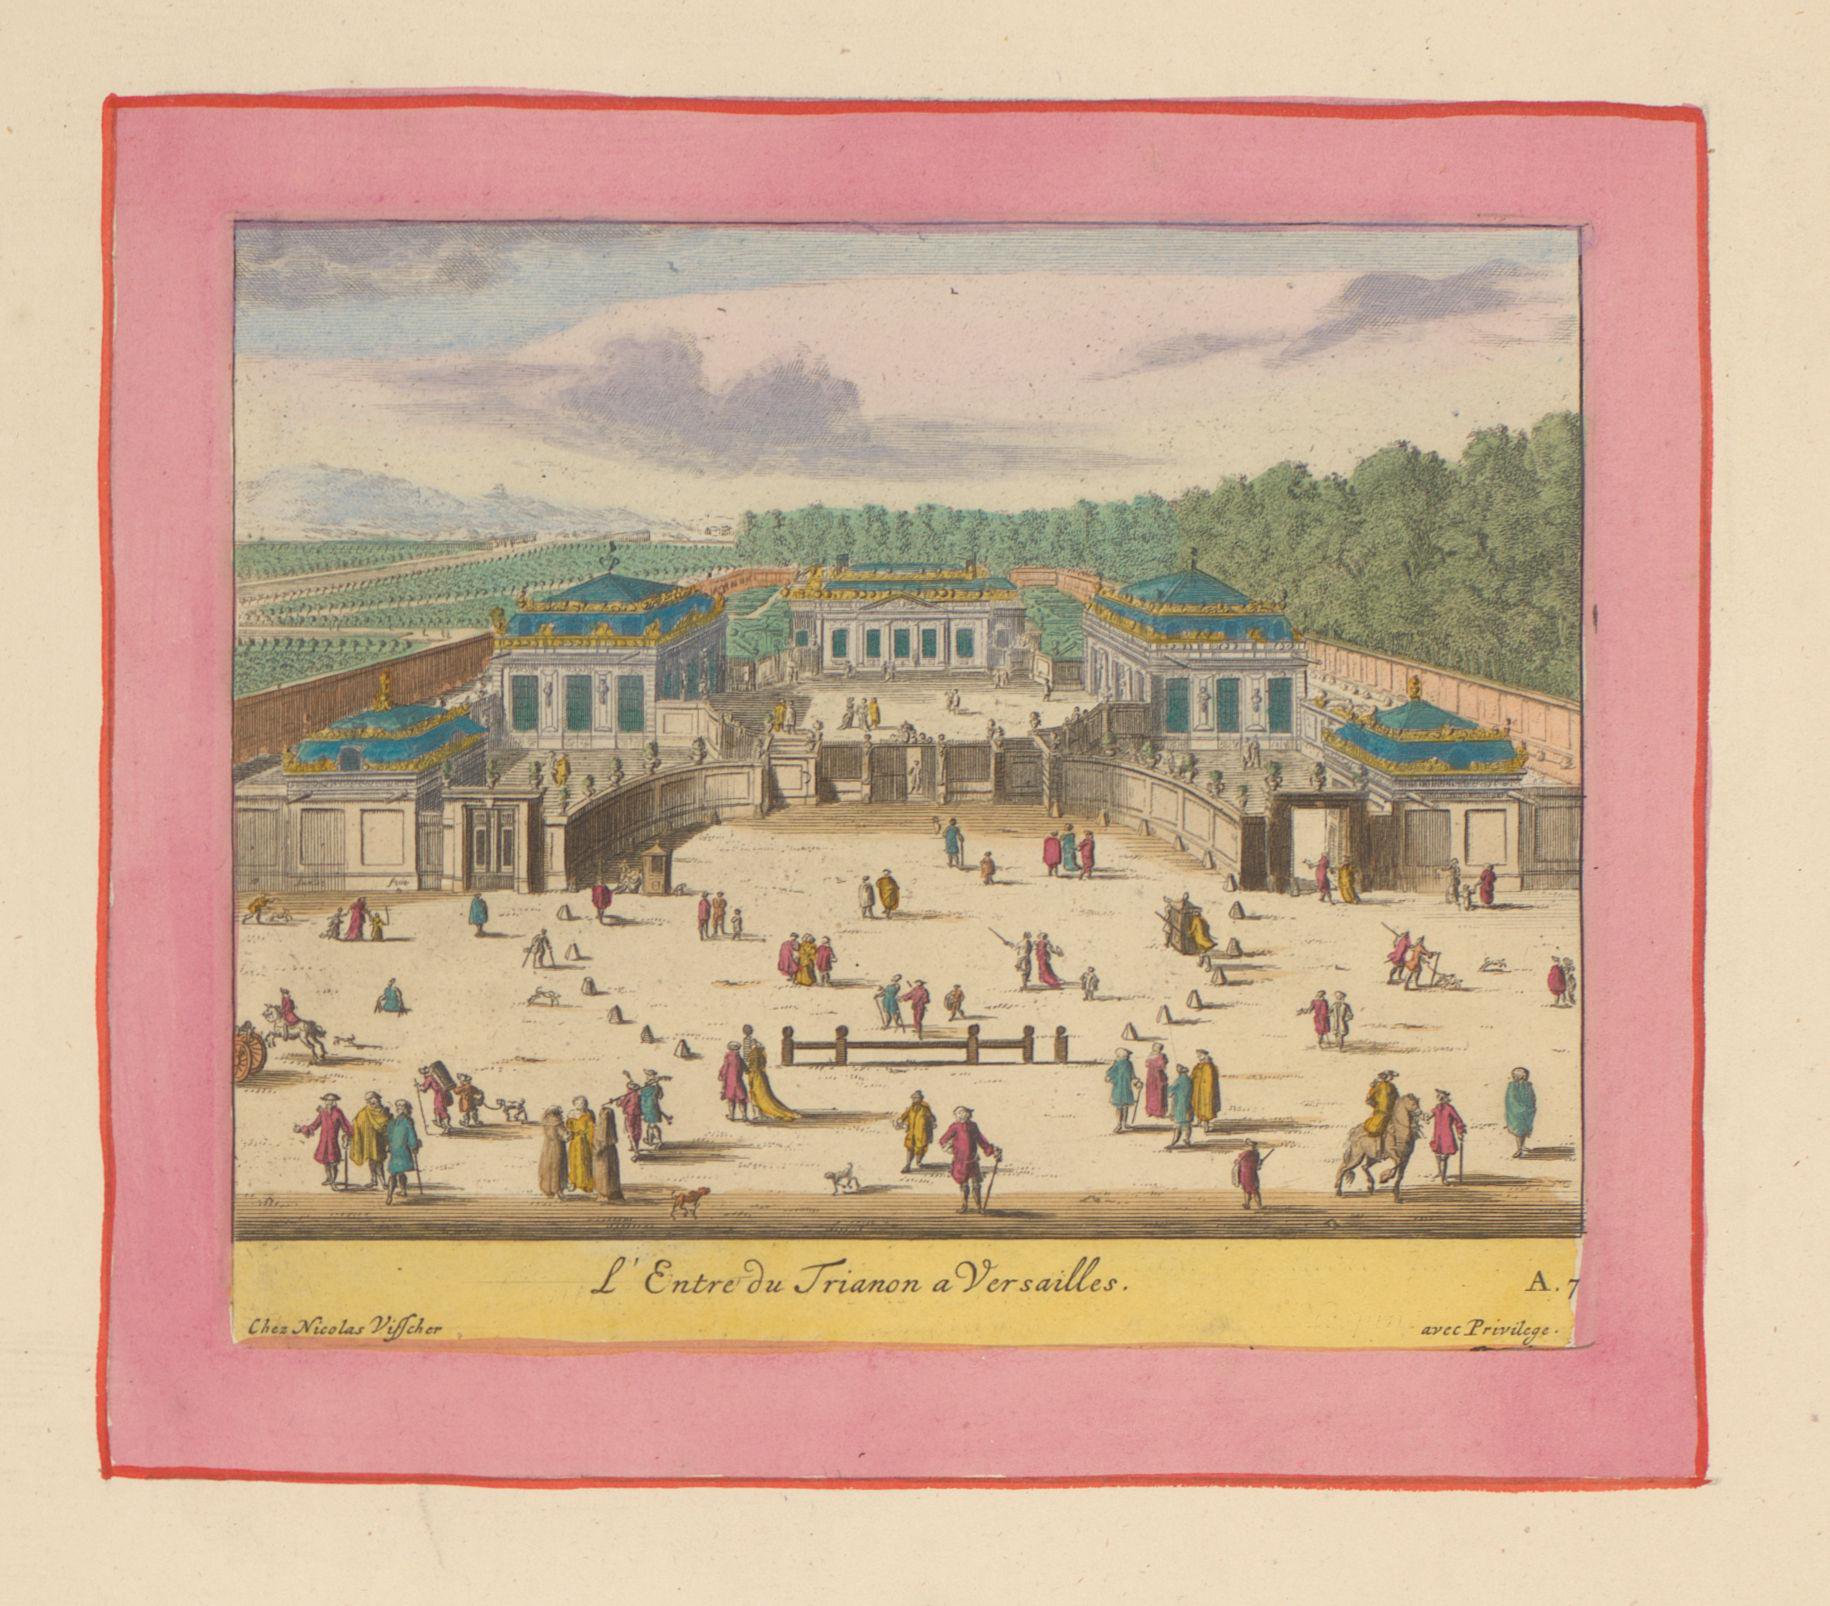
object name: album leaf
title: Veues de Versailles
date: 1686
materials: paper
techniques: etching, hand coloring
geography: amsterdam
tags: palace, french or architectonic garden; formal garden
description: De prent maakt deel uit van een serie bestaande uit 87 genummerde prenten (volgens Hollstein). De serie is opgedeeld in de delen A t/m F.